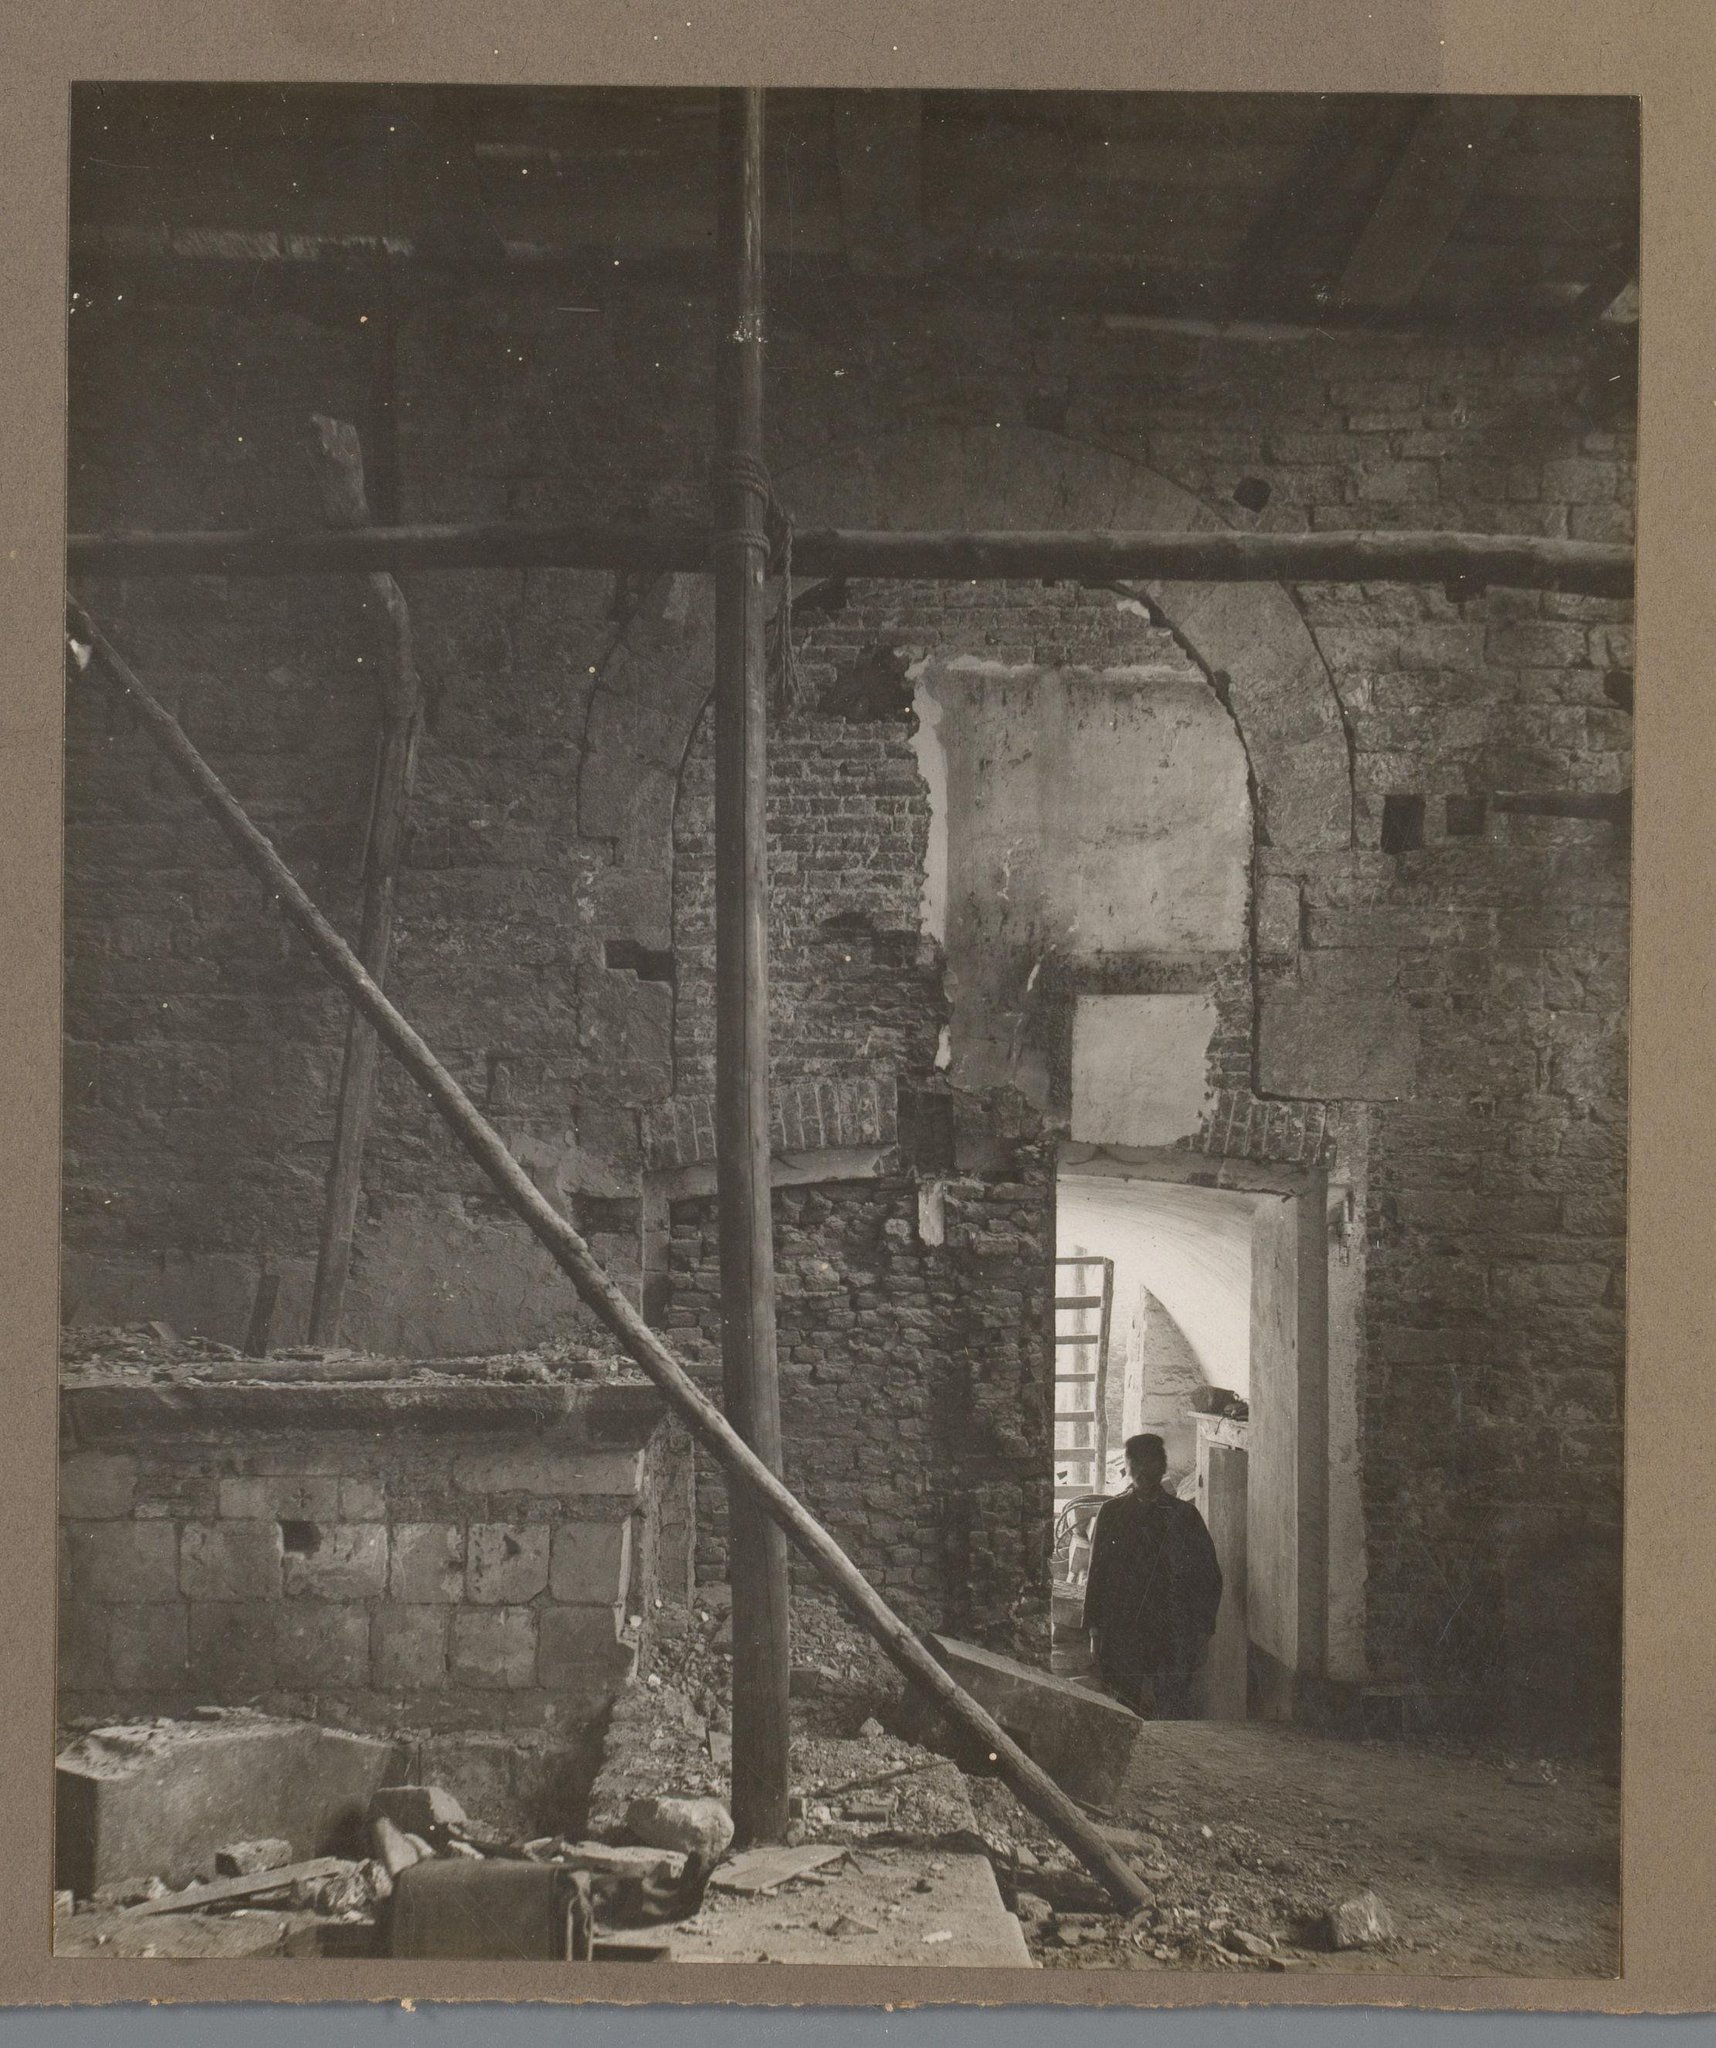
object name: photograph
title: Gestut gebouw dat aan het instorten is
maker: Anonymous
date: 1880-1920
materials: photographic support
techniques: gelatin silver print